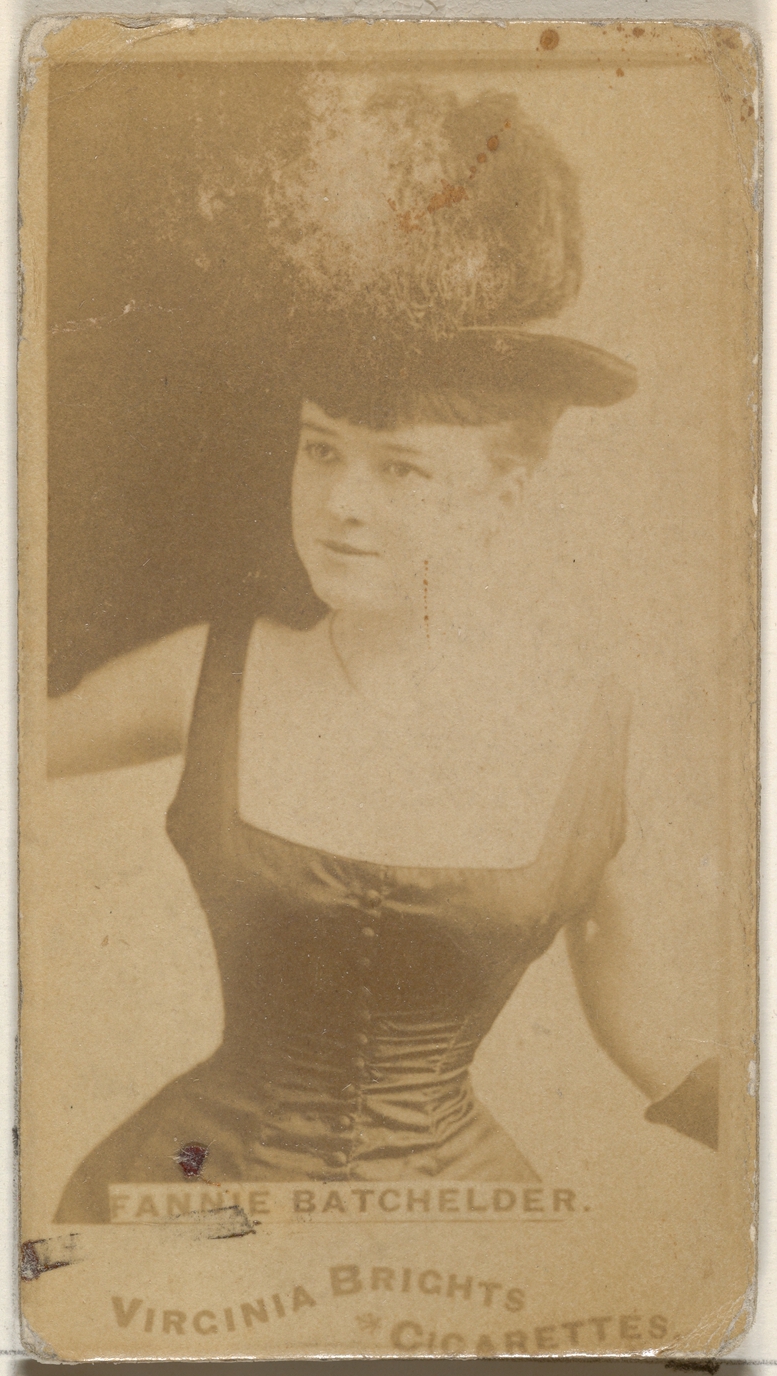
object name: photograph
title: Fannie Batchelder, from the Actors and Actresses series (N45, Type 1) for Virginia Brights Cigarettes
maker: allen & ginter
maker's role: publisher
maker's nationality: american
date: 1888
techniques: albumen silver print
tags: portraits,women,actresses